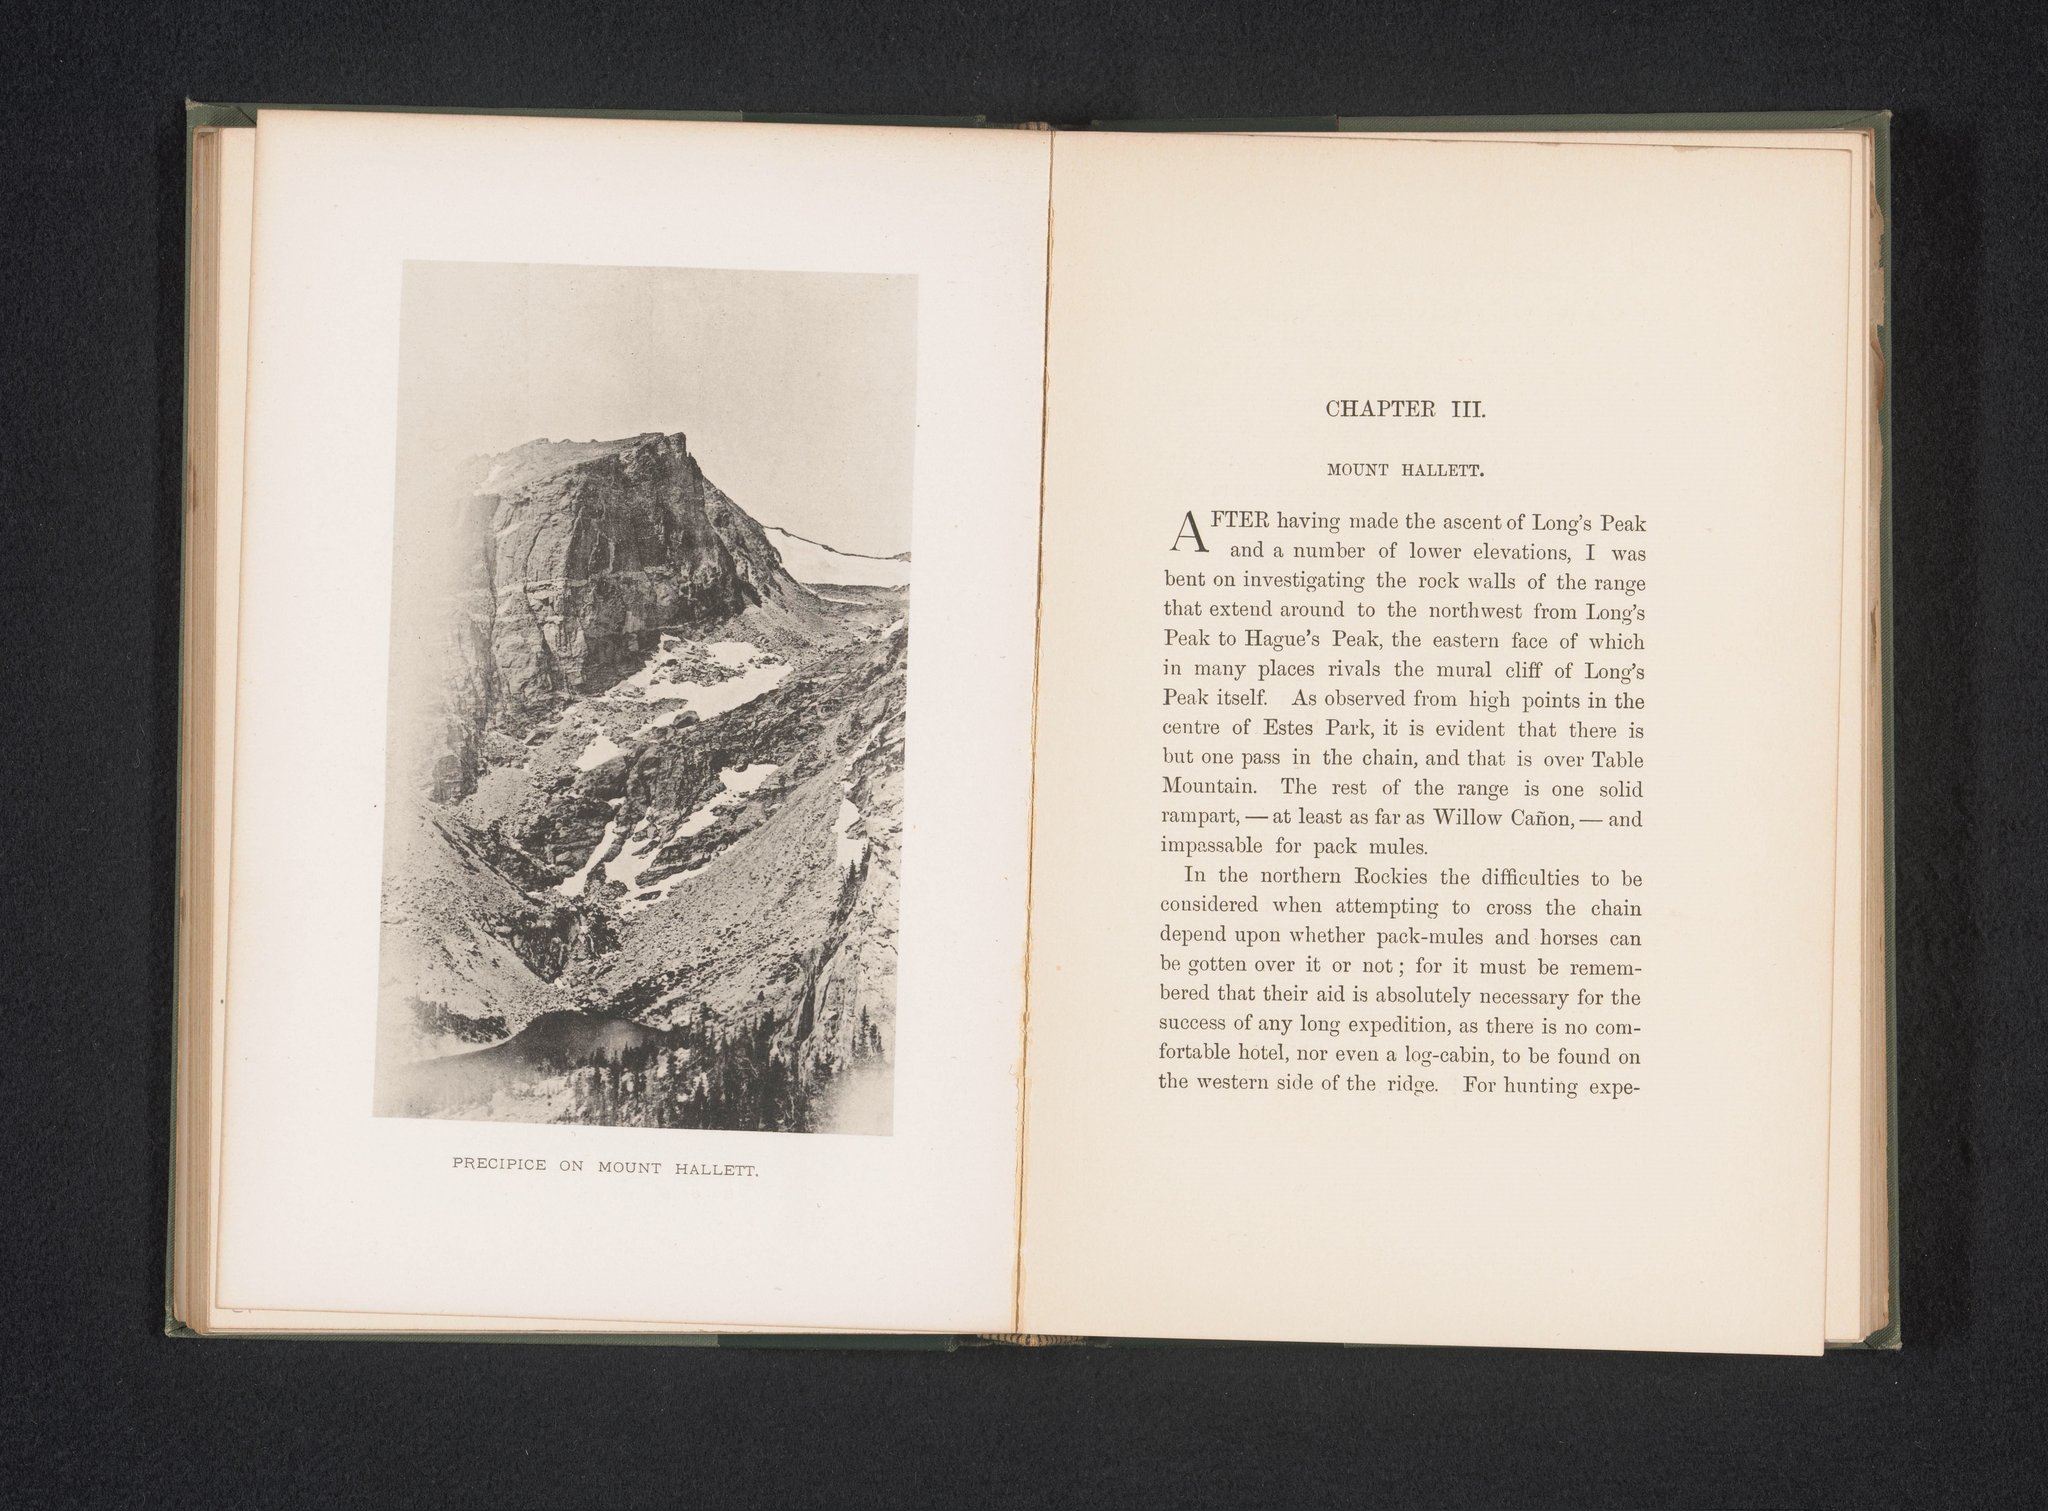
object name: page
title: Precipice on Mount Hallett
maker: frederick hastings chapin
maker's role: antropoloog, archeoloog, fotograaf, schrijver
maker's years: 1852-1900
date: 1885-1890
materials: paper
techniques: photograph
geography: rocky mountain national park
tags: mountain-top, peak, wildlife reserve, national park, mountains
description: Prent op twee ongenummerde pagina na pagina 68.